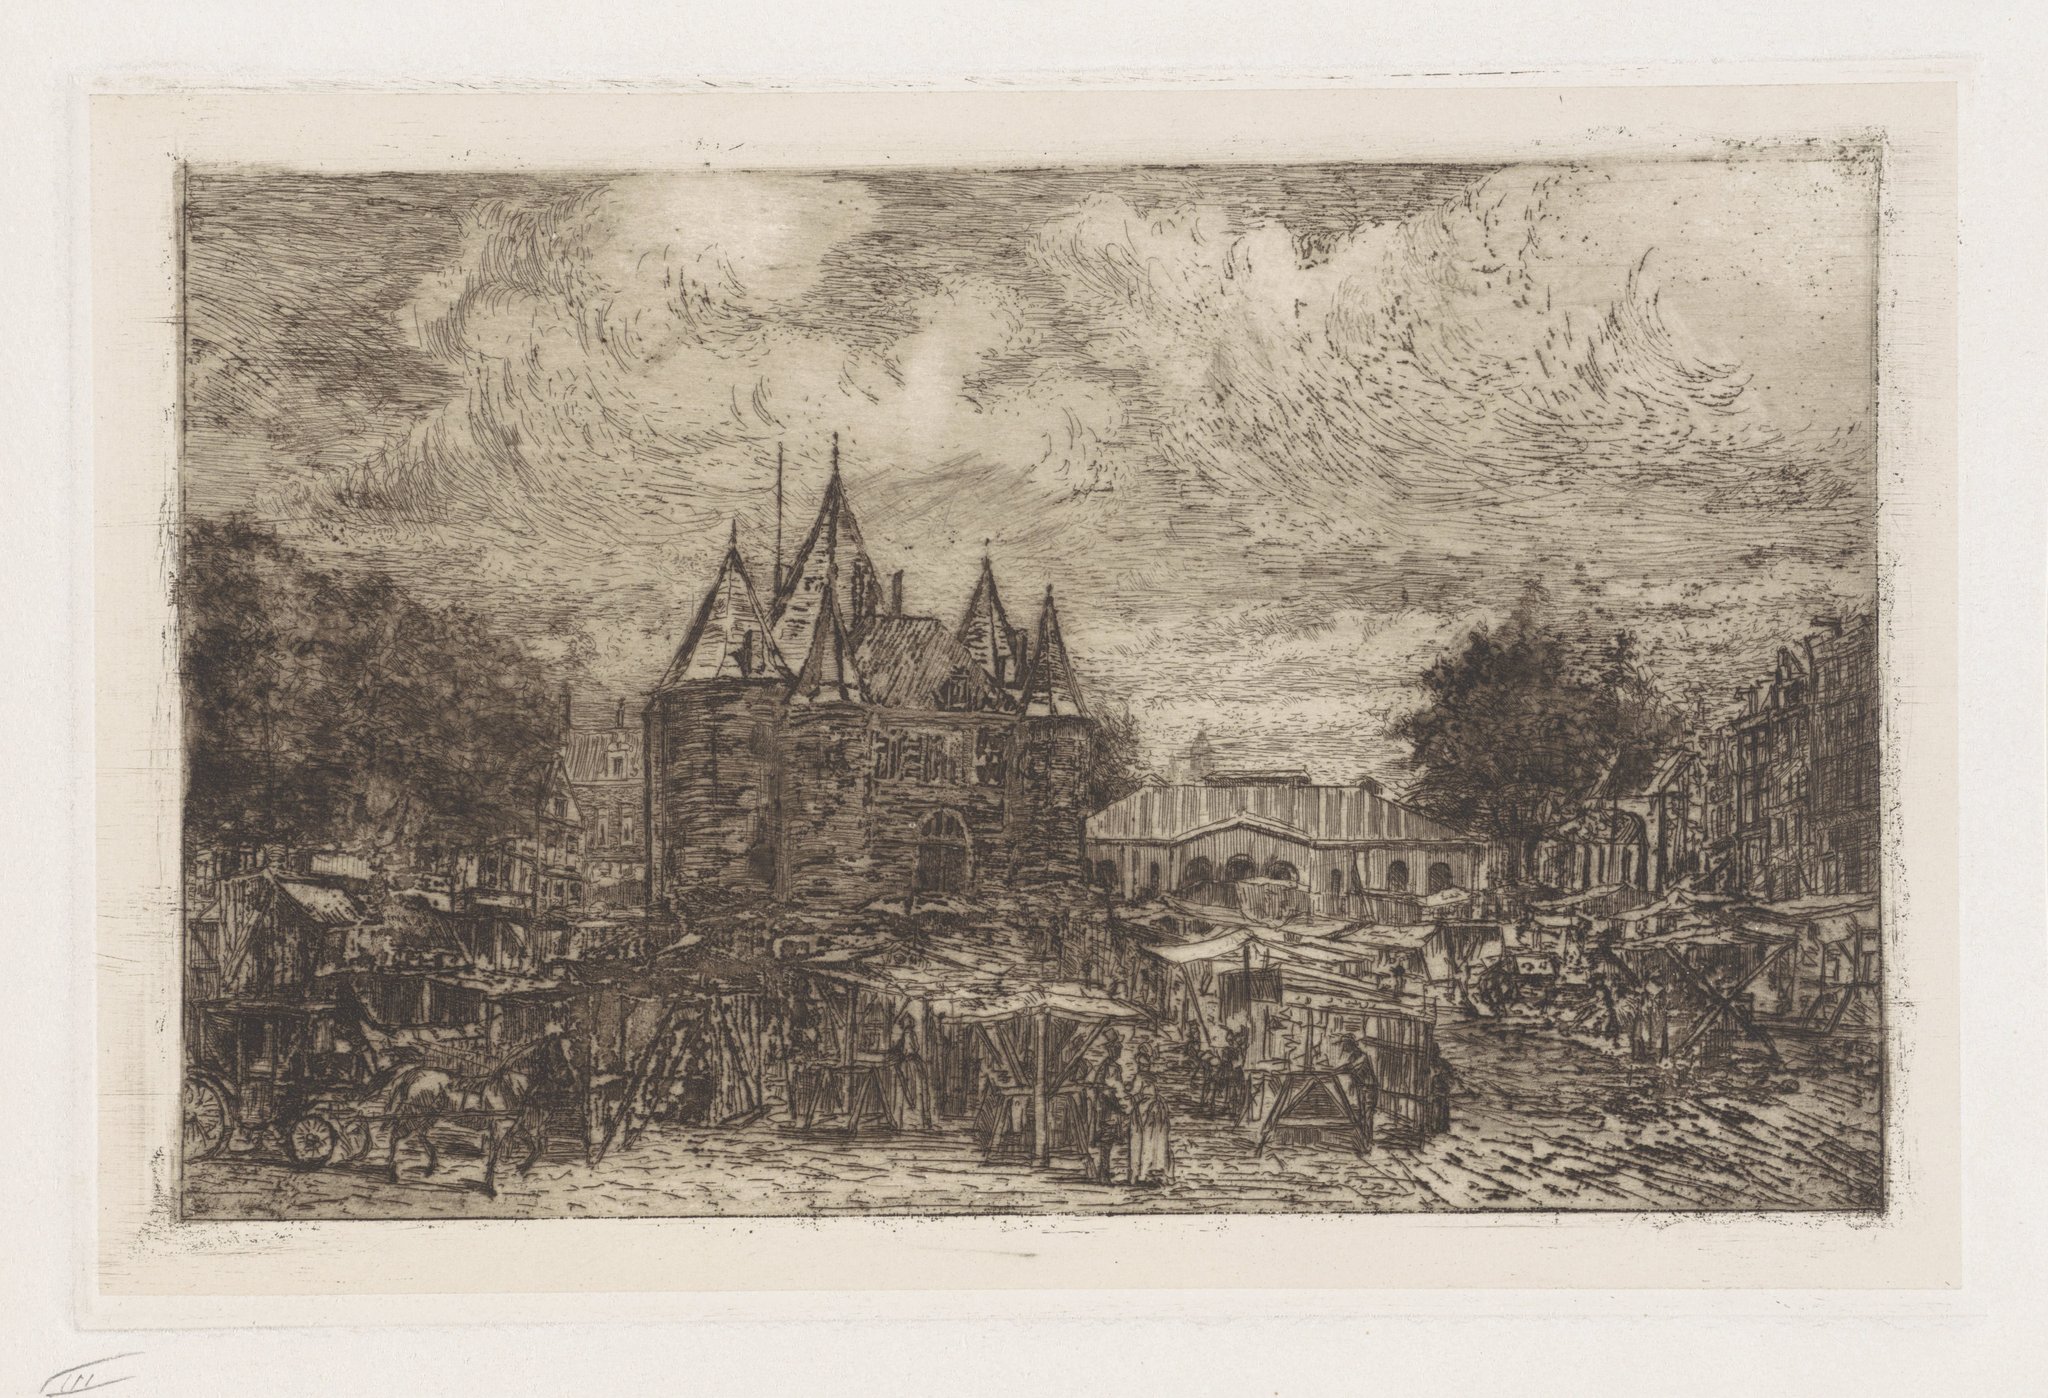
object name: print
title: Gezicht op de Nieuwmarkt, Amsterdam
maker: frans schikkinger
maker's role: print maker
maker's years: 1838-1902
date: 1848-1902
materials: paper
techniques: drypoint, etching, roulette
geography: amsterdam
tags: market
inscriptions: collector's mark: Lugt 2228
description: Gezicht op de Nieuwmarkt en de Waag. Het plein is gevuld met marktstalletjes.